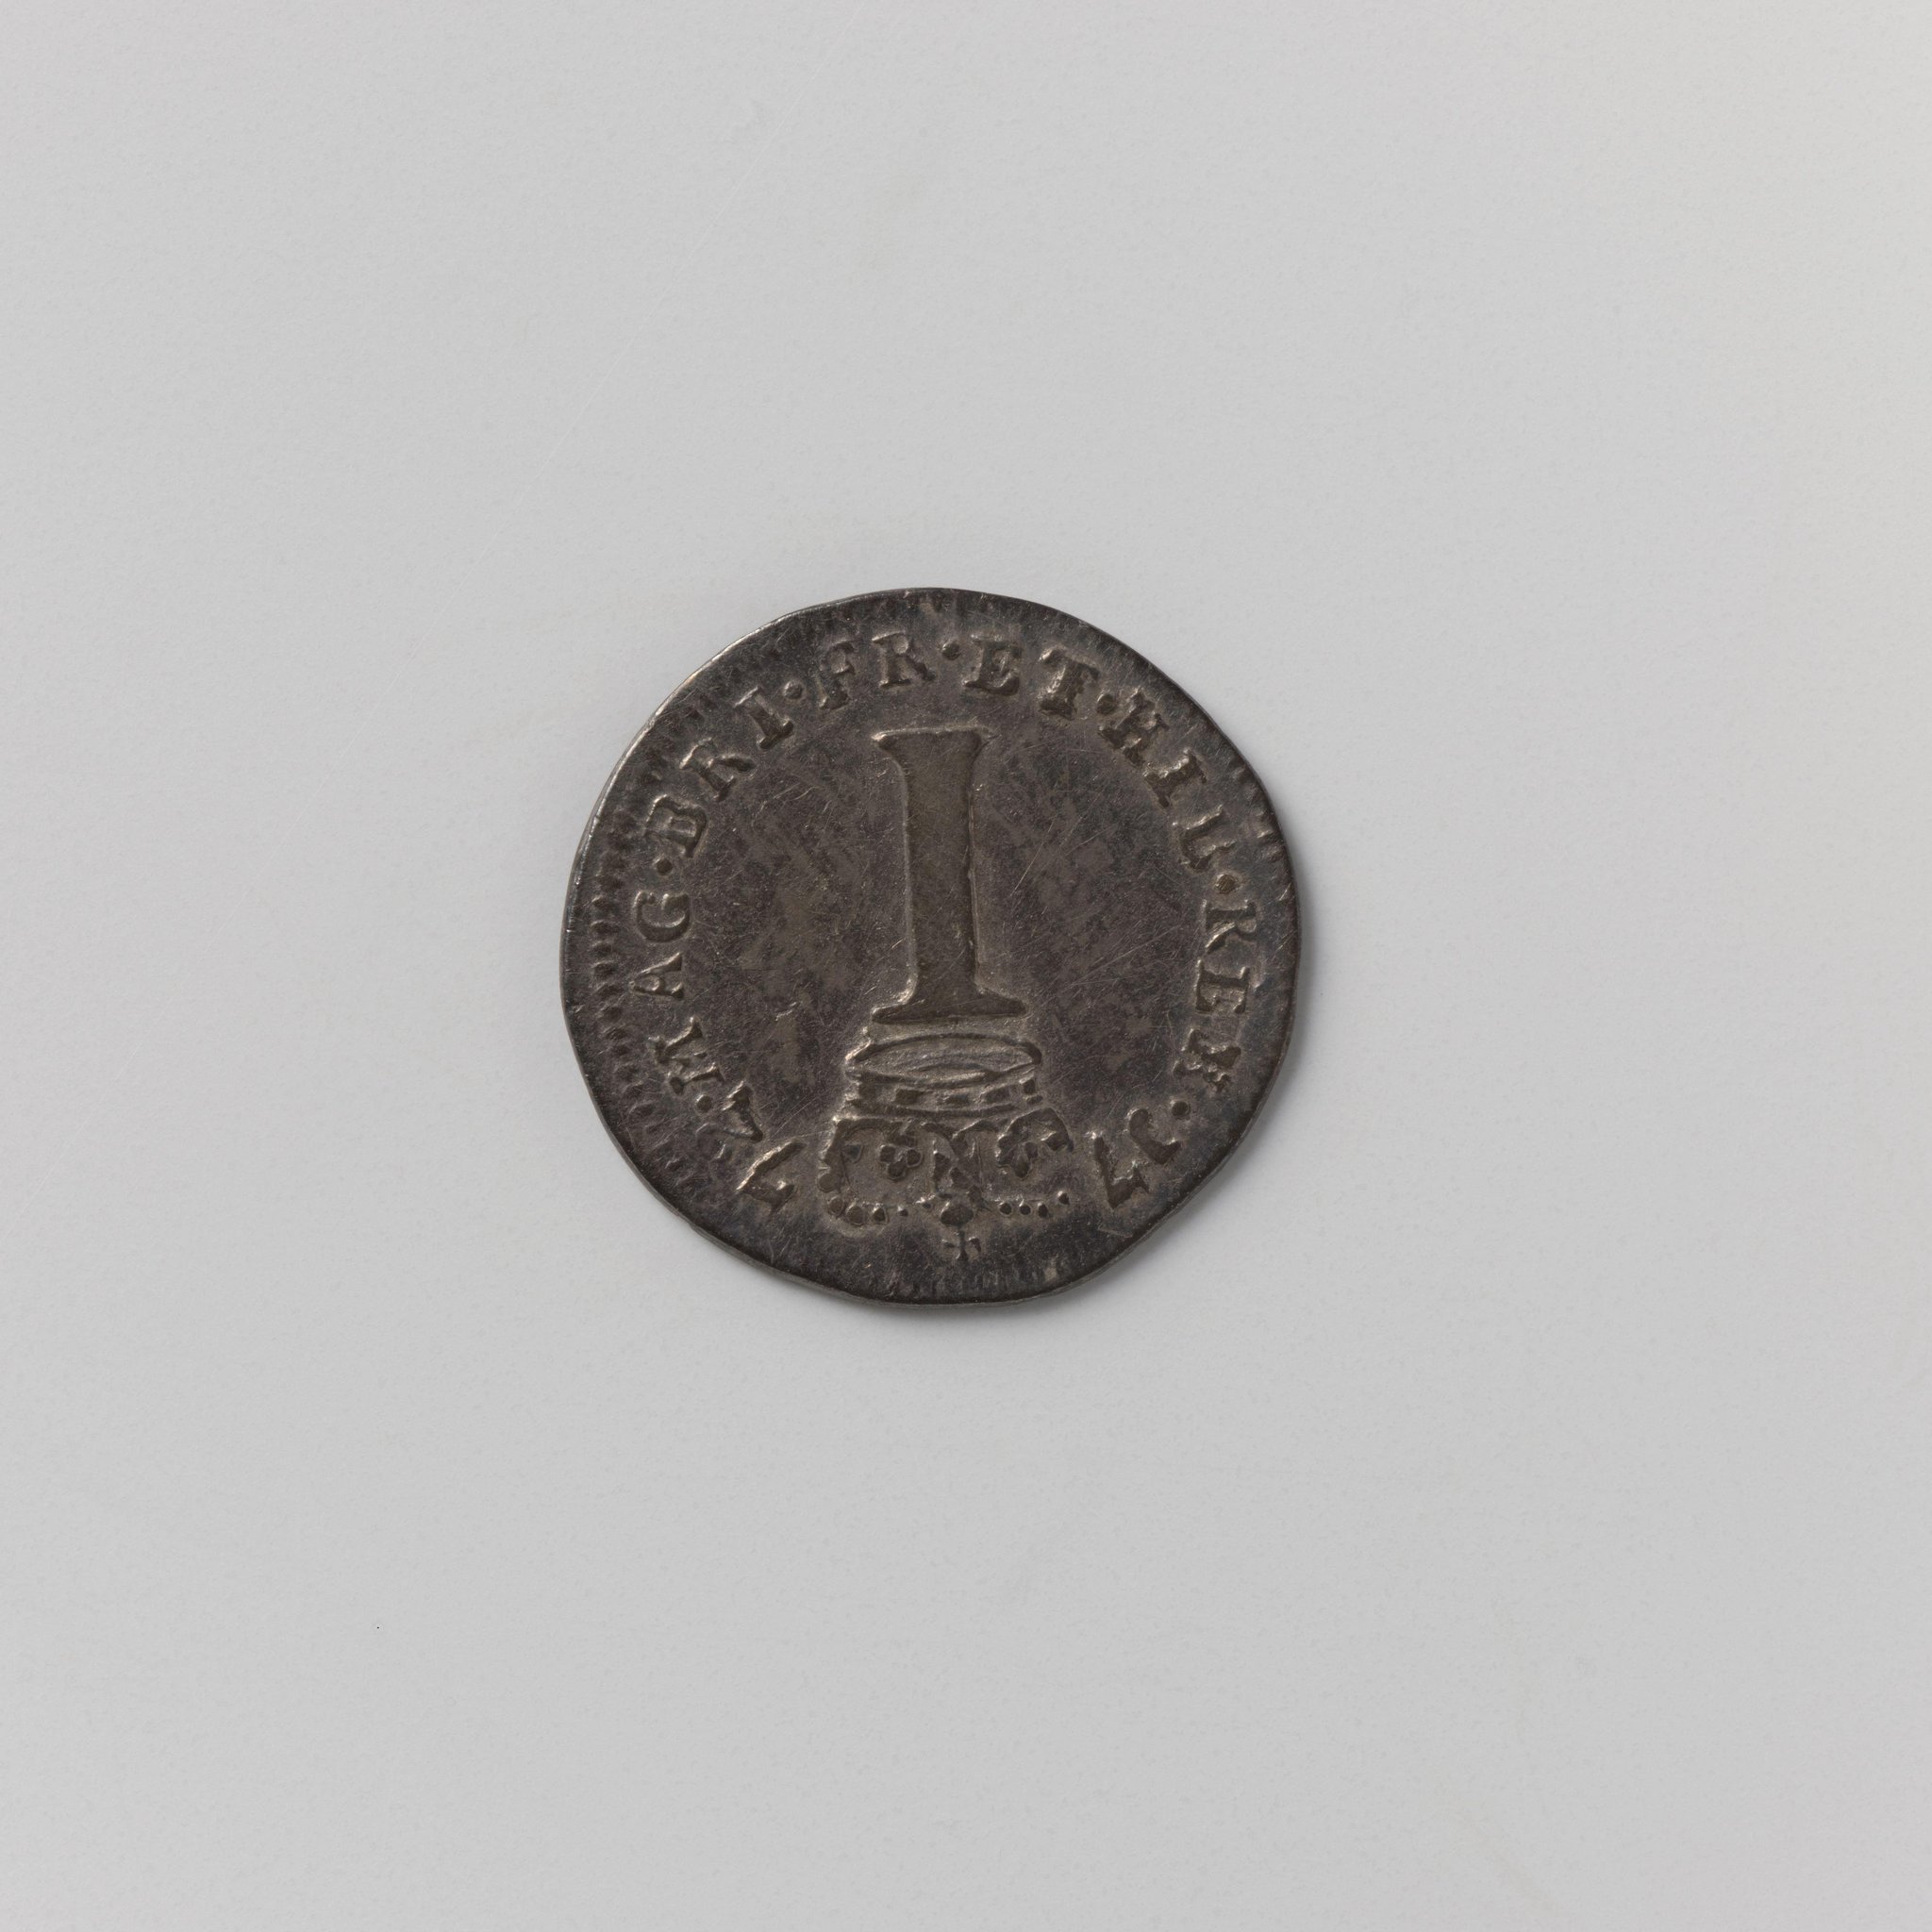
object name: coin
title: Engeland, George III, penny, 1772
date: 1772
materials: silver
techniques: striking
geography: london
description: Zilveren munt. Voorzijde: gelauwerd borstbeeld van de koning naar rechts. Keerzijde: gekroond cijfer een. Jaartal bovenaan rondom kroon. Maundy Money.